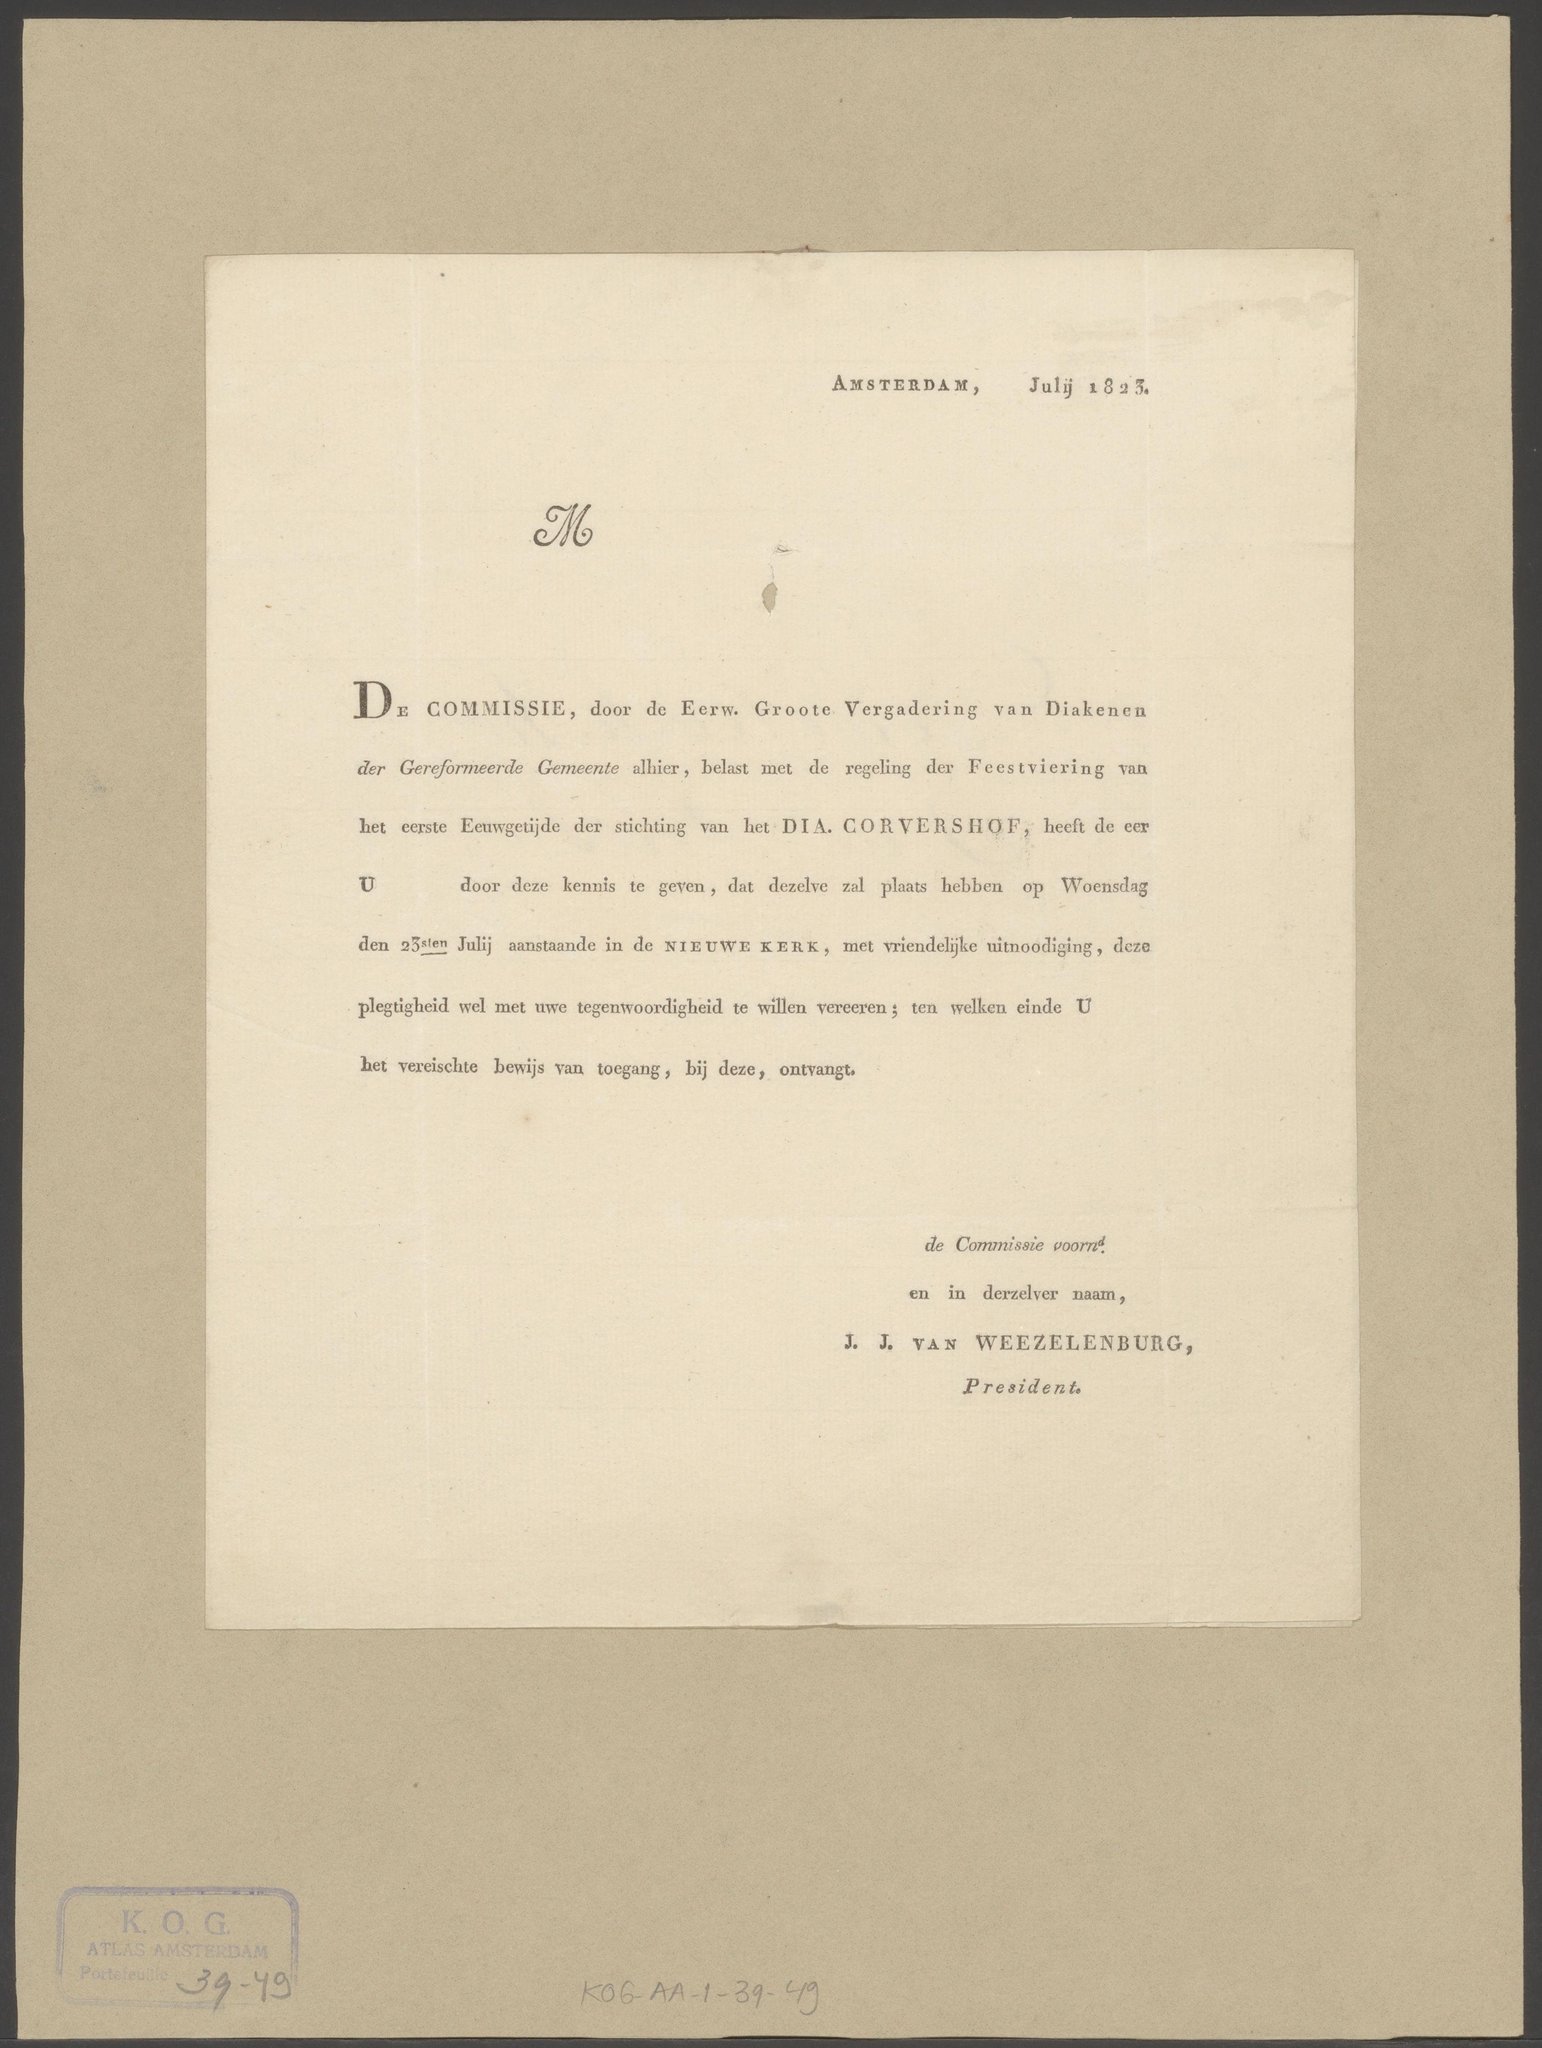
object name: invitation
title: Uitnodiging voor het eerste eeuwfeest van het Corvershof te Amsterdam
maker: Anonymous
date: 1807-1823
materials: paper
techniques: letterpress printing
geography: netherlands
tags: alms-house (dutch: 'hofje'), commemoration, jubilee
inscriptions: collector's mark: Lugt 1641b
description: Object bestaat uit een bifolium, met op verso van het tweede blad de handgeschreven naam van de vermoedelijke geadresseerde - "De Wel Edele Heer J. de Vries" - en een restant van de zegellak. Onderwerpsrubriek binnen de Atlas Amsterdam: Armwezen en liefdadige instellingen: III. Verschillende gestichten en instellingen / Hofjes: Corvershof der N. Hervormde Gemeente.